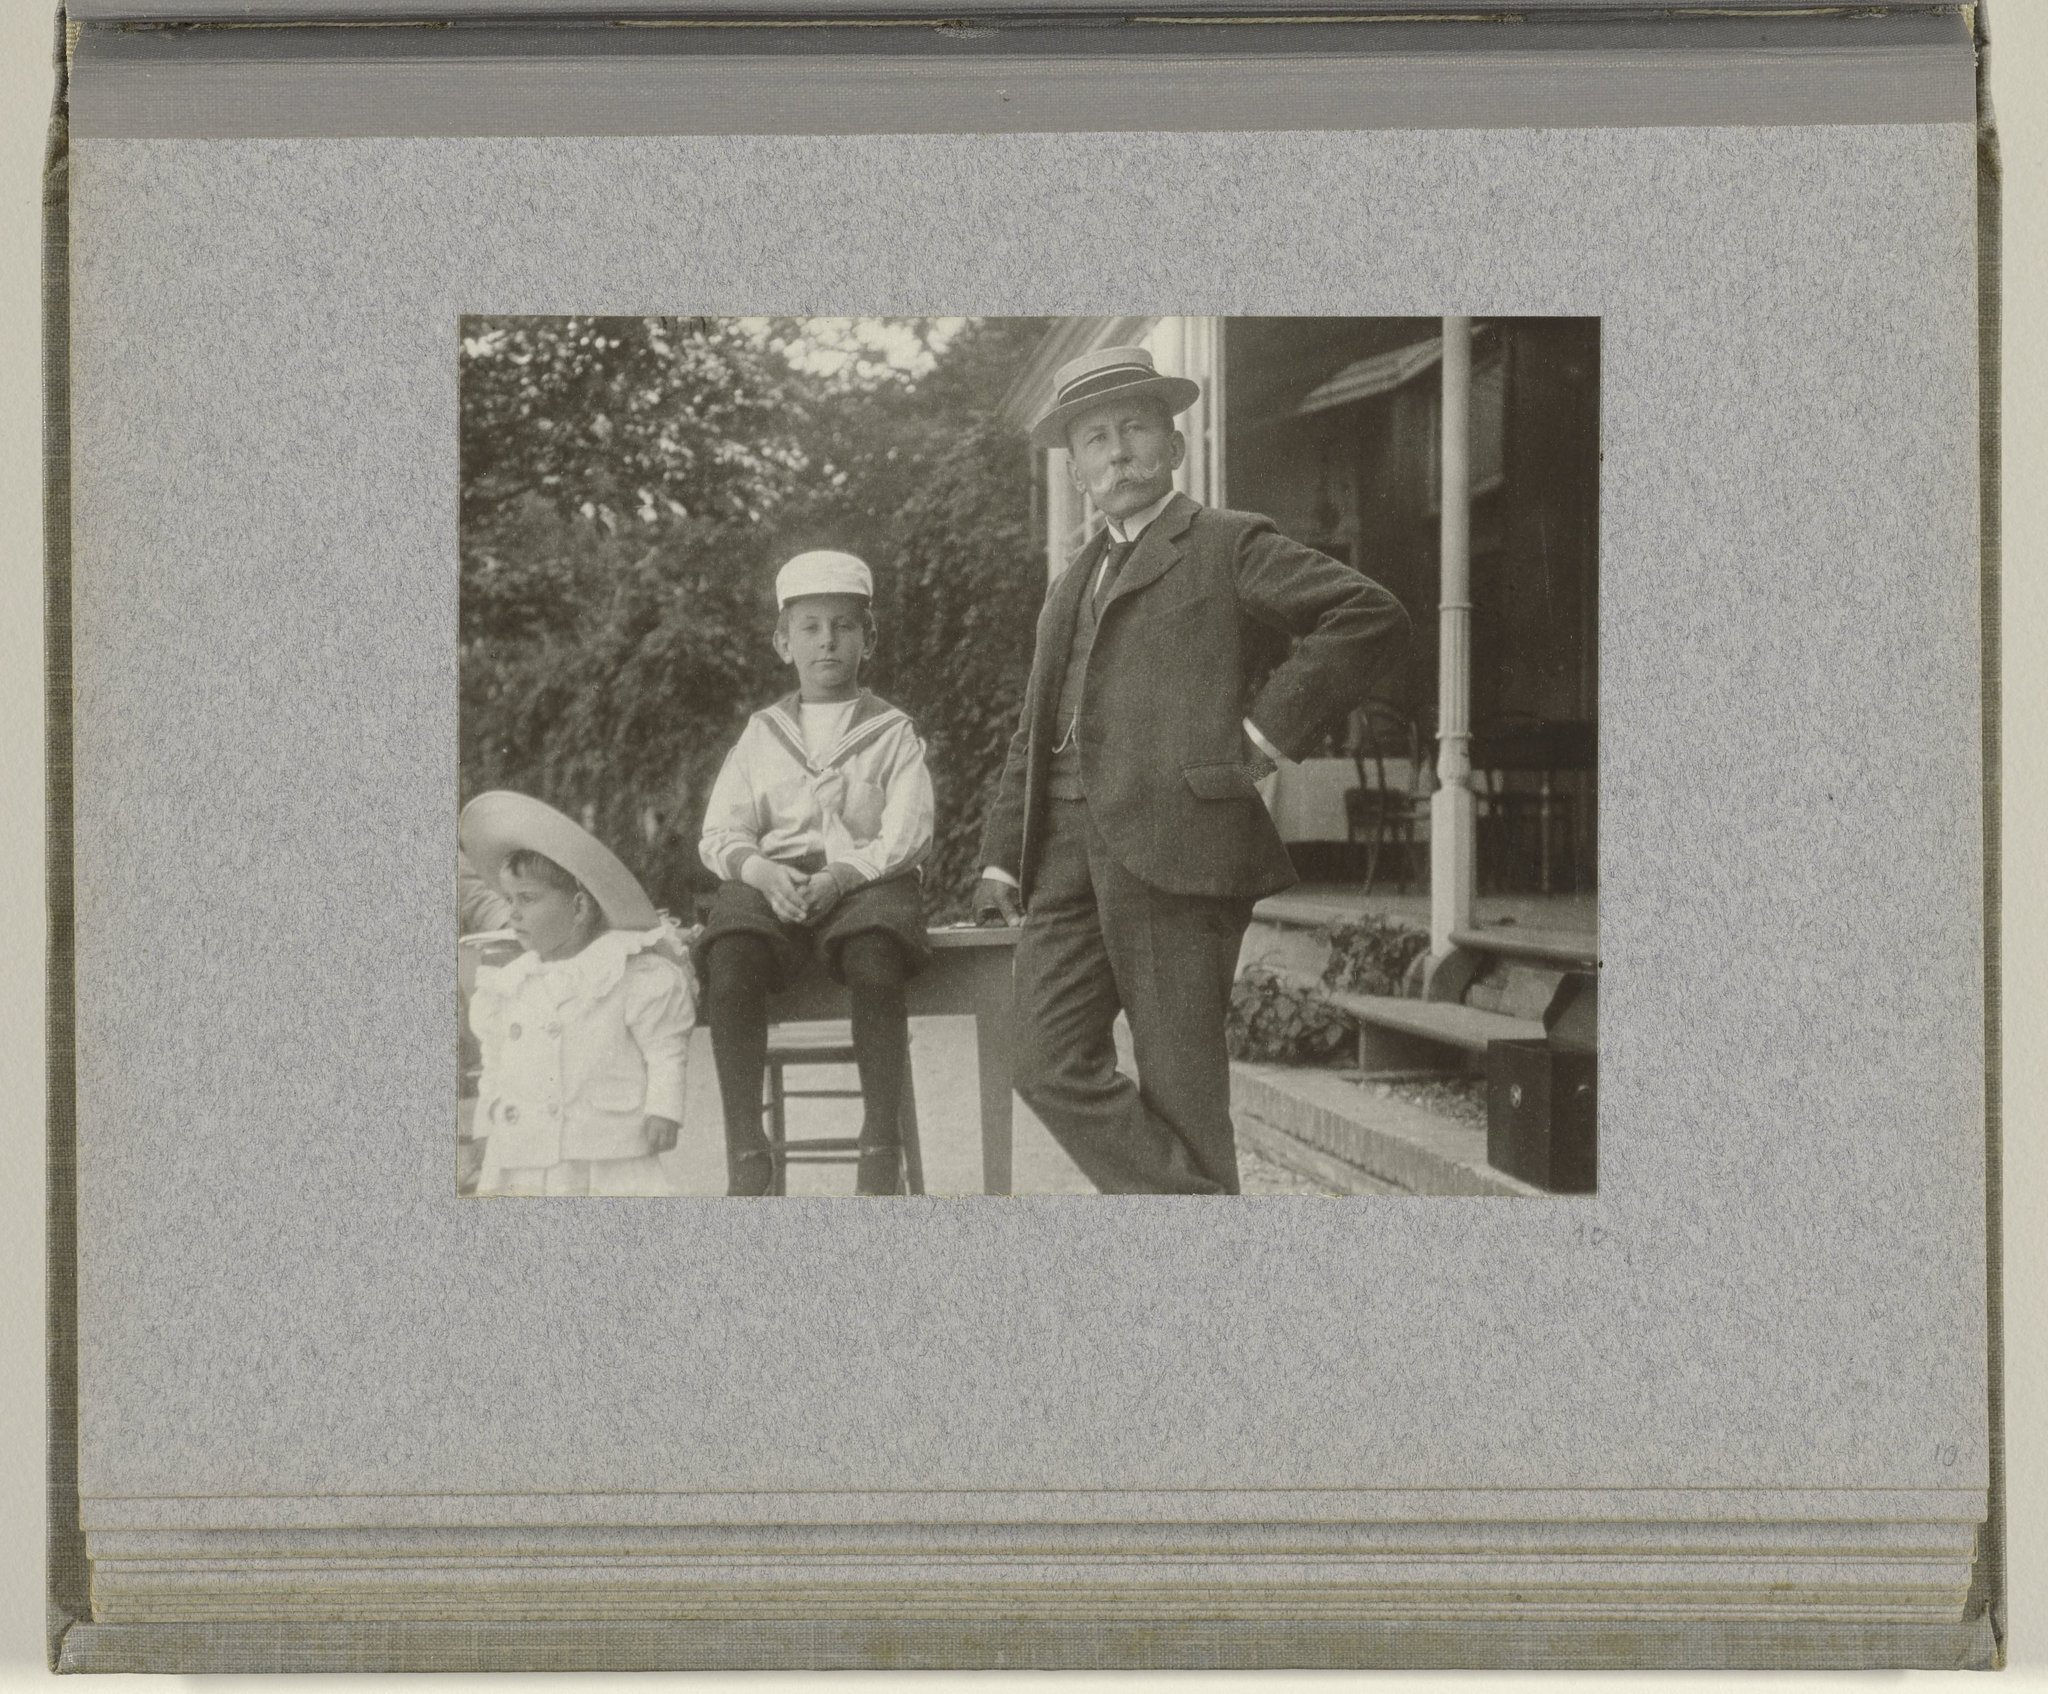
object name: photograph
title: J.B. Aug. Kessler met naast zich twee van zijn kinderen voor de veranda, foudraal rechtsonder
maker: geldolph adriaan kessler (dolph)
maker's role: fotograaf, industrieel, voetballer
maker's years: 1884-1945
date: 1900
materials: paper, photographic support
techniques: gelatin silver print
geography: netherlands